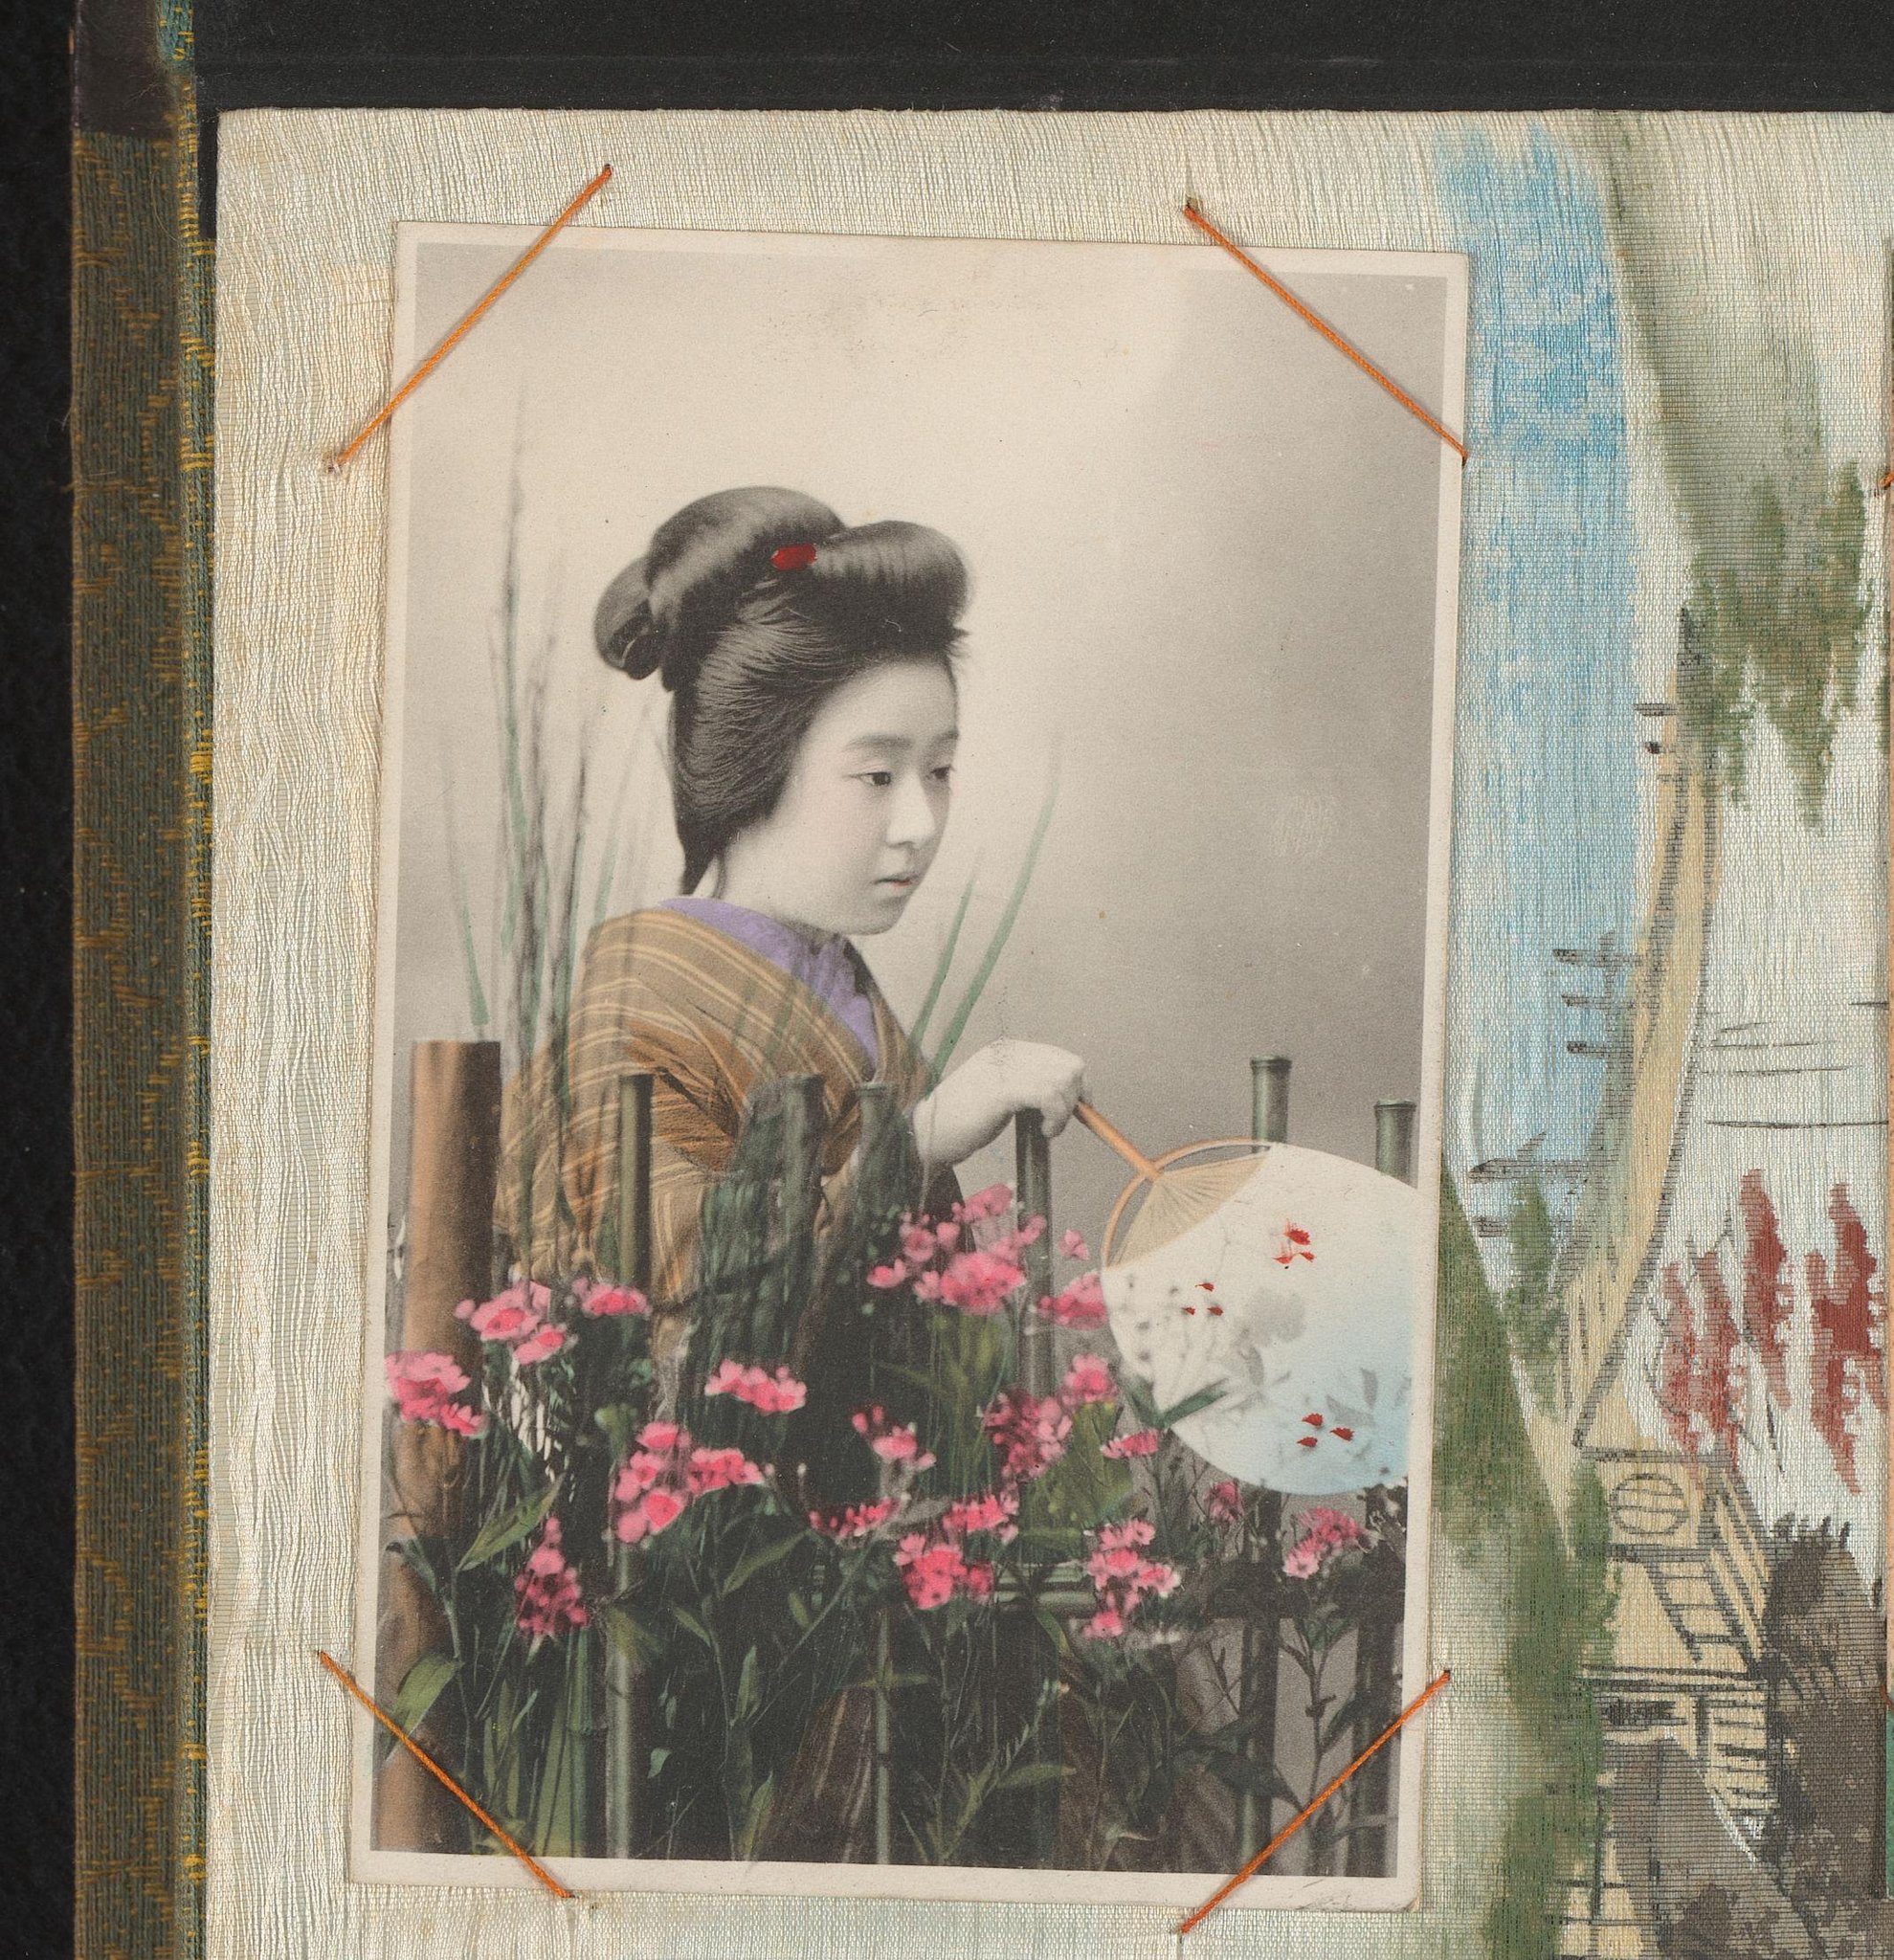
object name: photomechanical print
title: Japanse vrouw staande achter een hek met planten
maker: Anonymous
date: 1900-1920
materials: paper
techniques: photograph, hand coloring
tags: historical persons - bb - woman, folk costume, regional costume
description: Deze prent maakt deel uit van een album.